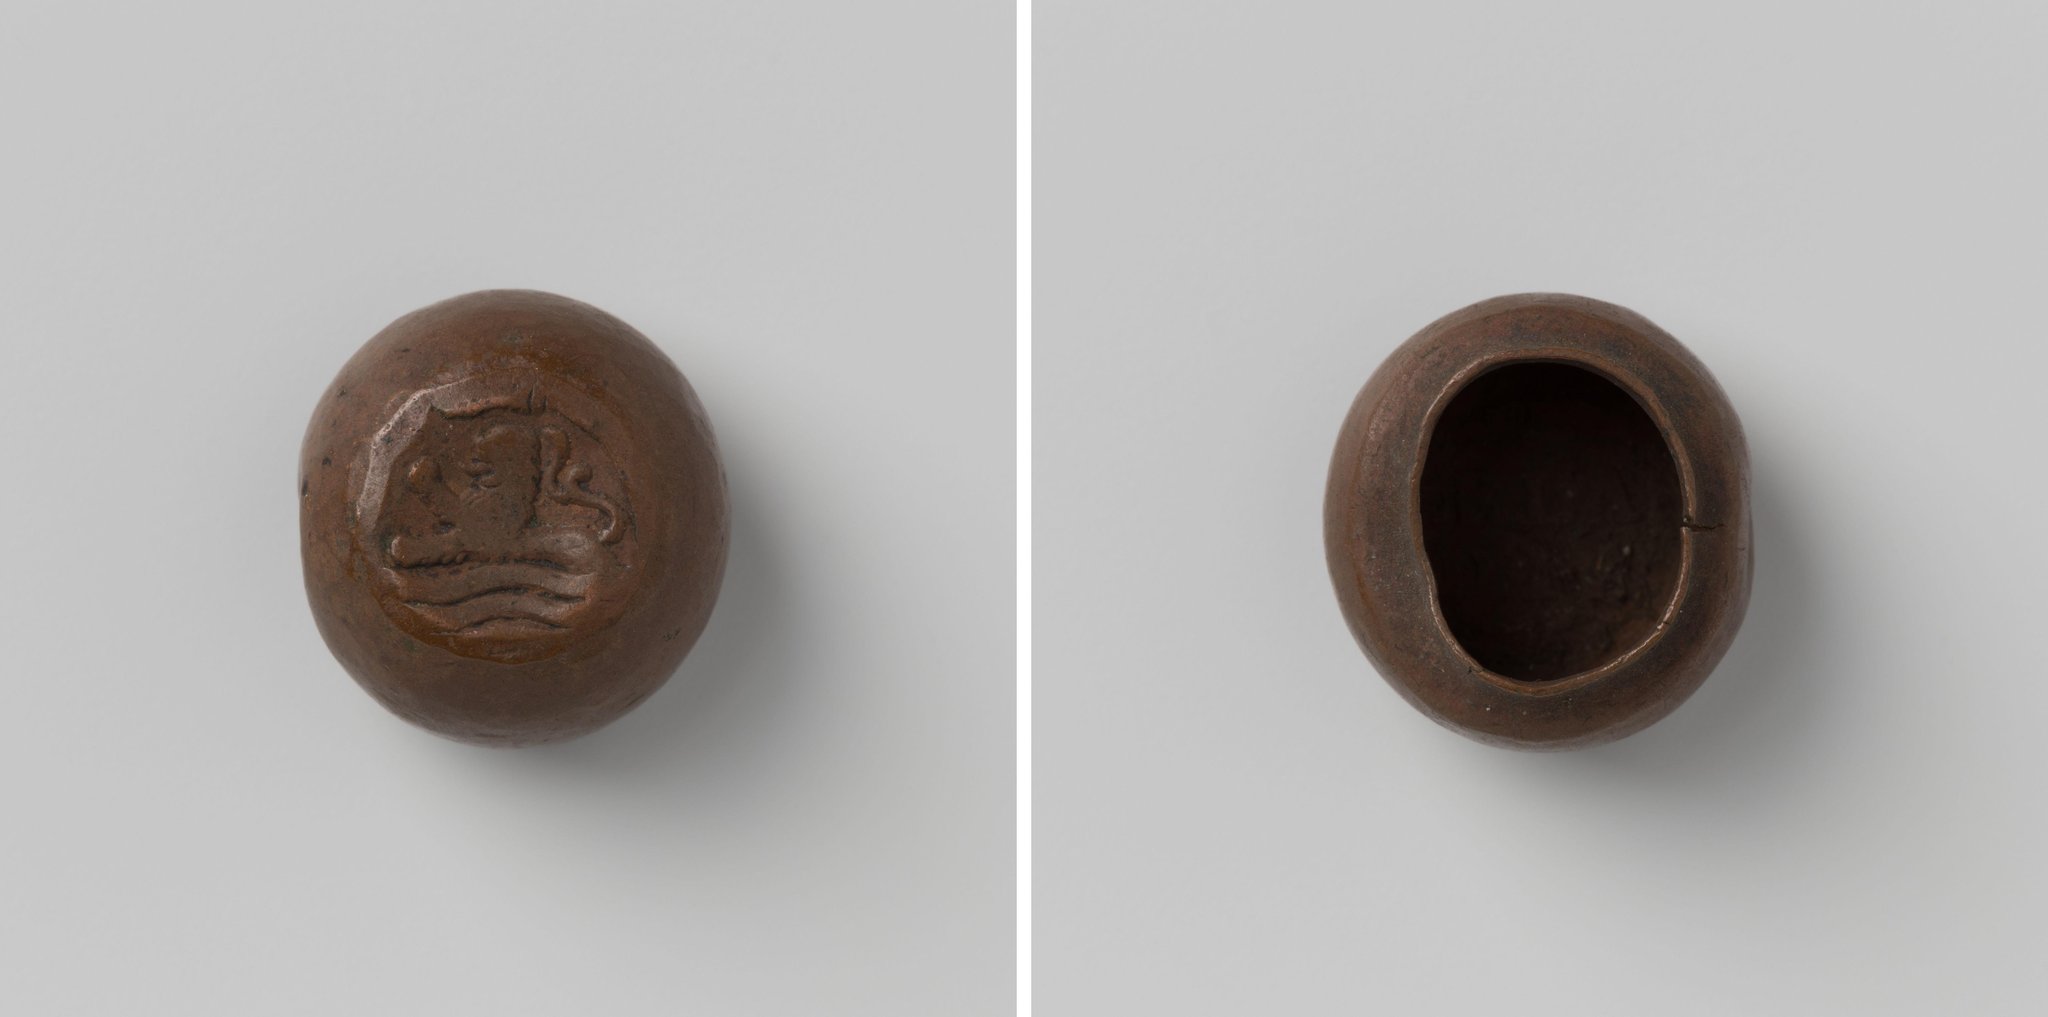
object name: kettle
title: Miniatuurketel, vervaardigd uit duit van provincie Zeeland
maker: Anonymous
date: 1600-1700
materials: copper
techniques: striking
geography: middelburg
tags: zeeland